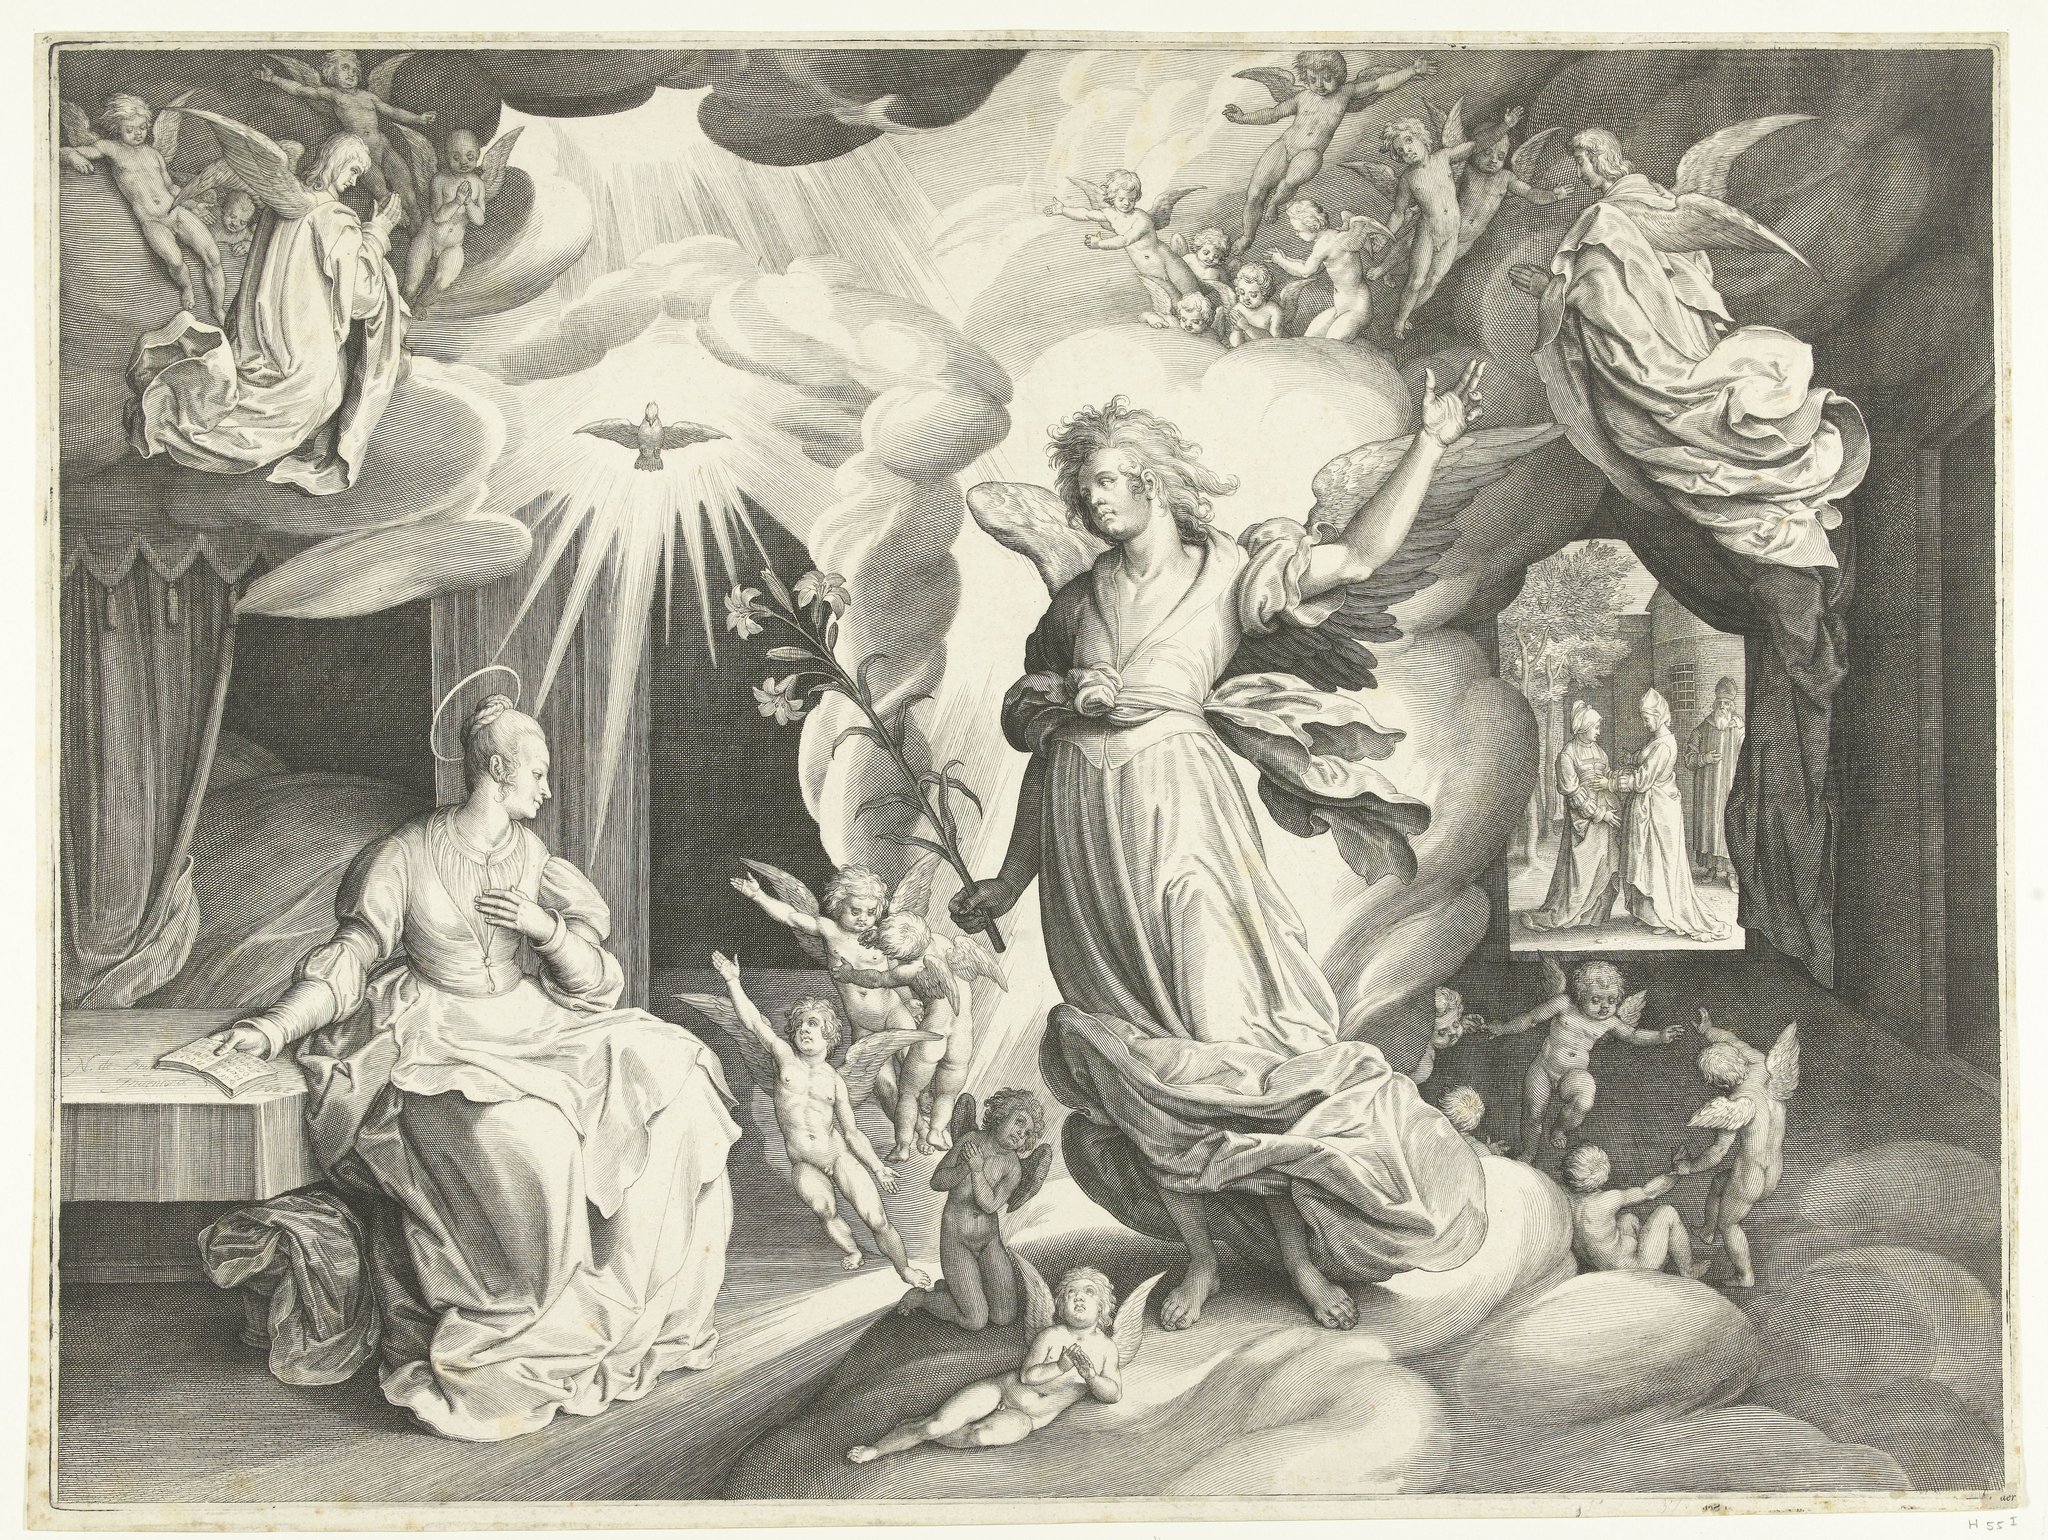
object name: print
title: Annunciatie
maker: nicolaes de bruyn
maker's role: print maker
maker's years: 1571-1656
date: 1622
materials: paper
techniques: engraving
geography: netherlands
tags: the annunciation: mary, usually reading, is visited by the angel (sometimes a woman overhears the conversation)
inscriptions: collector's mark: Lugt 2228